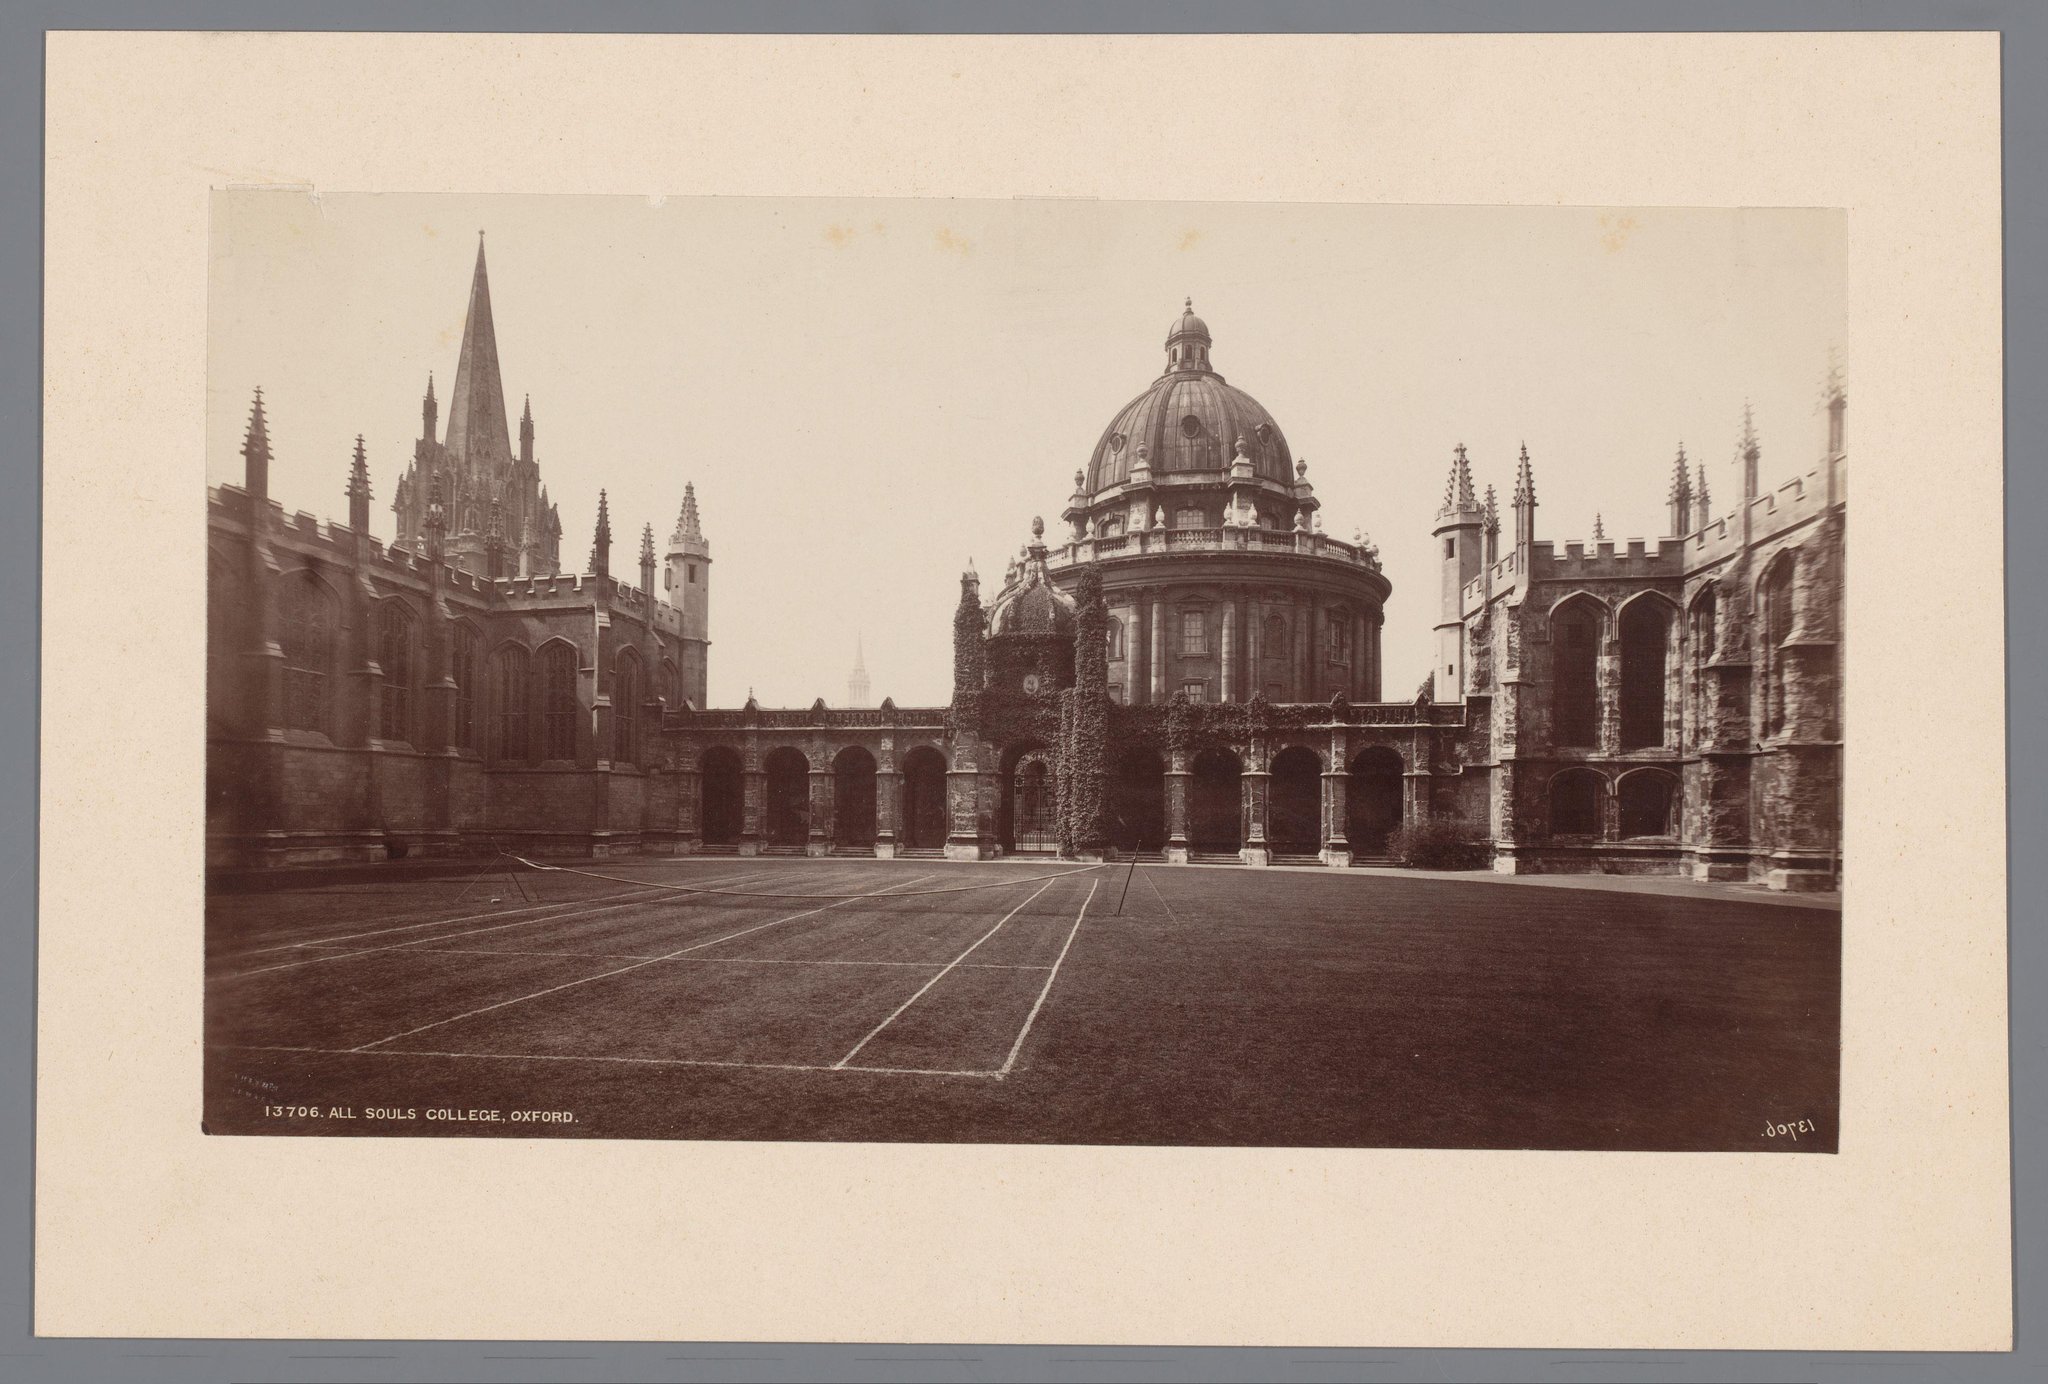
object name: photograph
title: All Souls College, Oxford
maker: francis frith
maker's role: publisher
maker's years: 1822-1898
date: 1864-1898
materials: cardboard, paper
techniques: albumen print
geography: oxford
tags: university building, college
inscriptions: number: ‘13706.’